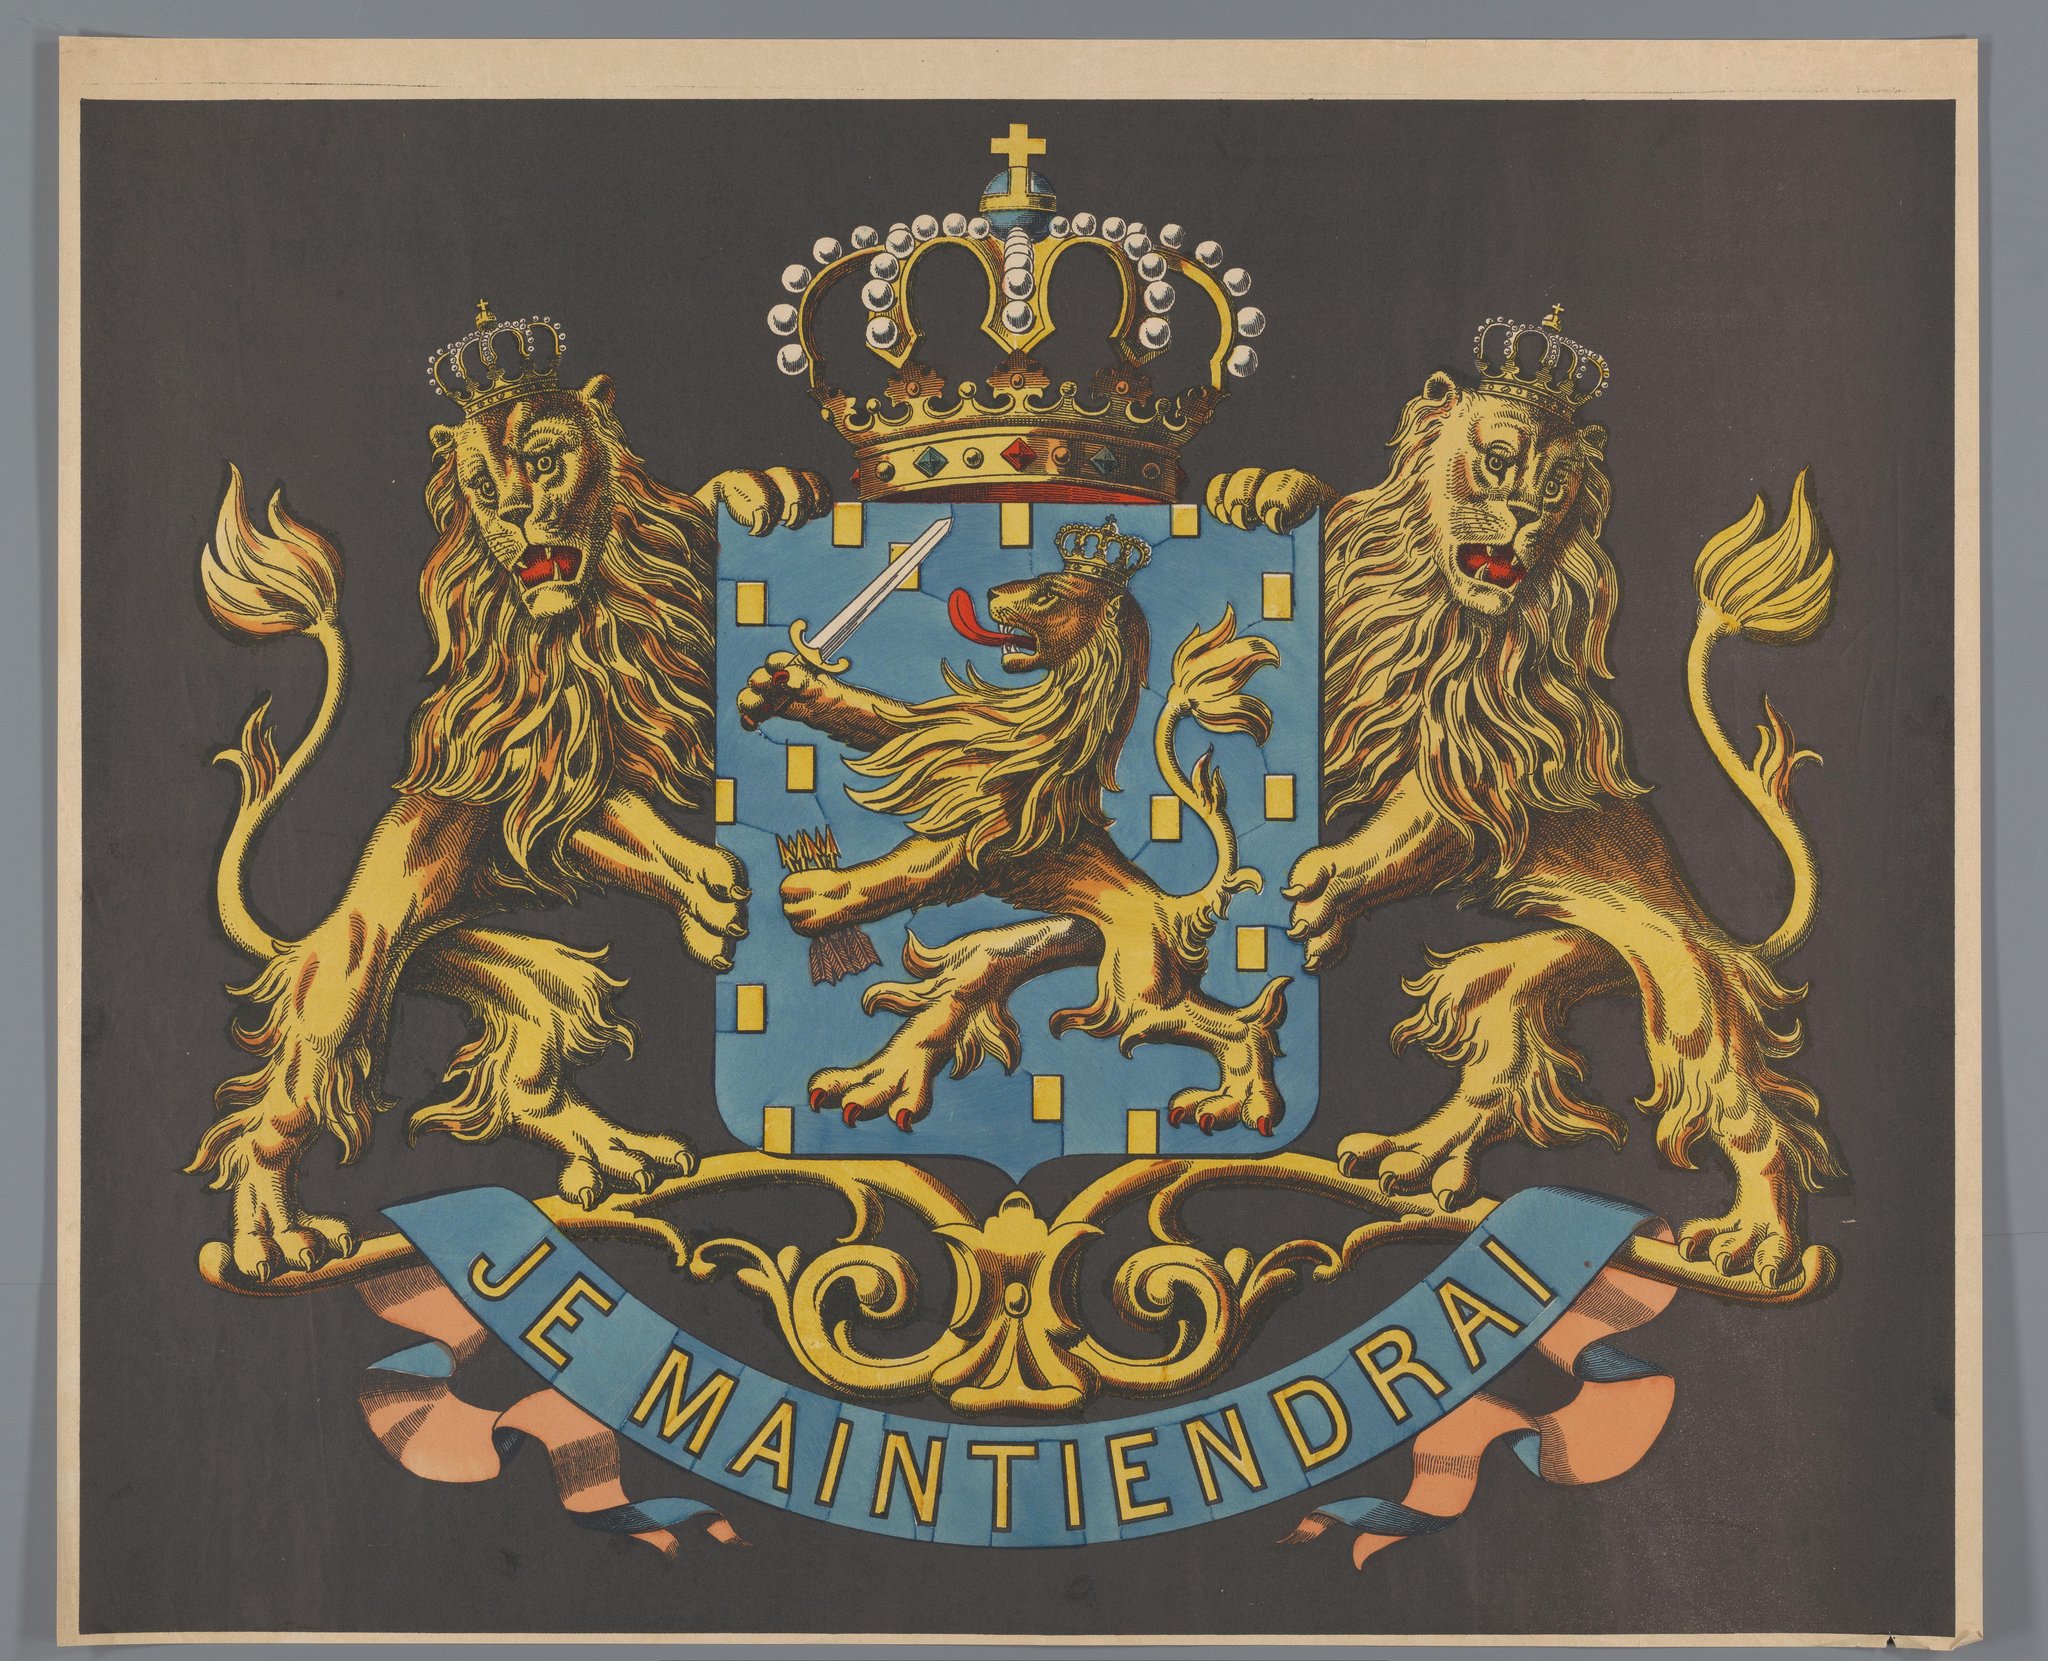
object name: print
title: Wapen van het Koninkrijk der Nederlanden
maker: Anonymous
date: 1850-1950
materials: paper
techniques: lithograph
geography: netherlands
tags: coat of arms (as symbol of the state, etc.), netherlands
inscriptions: annotation: ‘uit dêpot VIII 2000 Rijkswapen’, collector's mark: Lugt 2228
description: Rijkswapen van het Koninkrijk der Nederlanden.